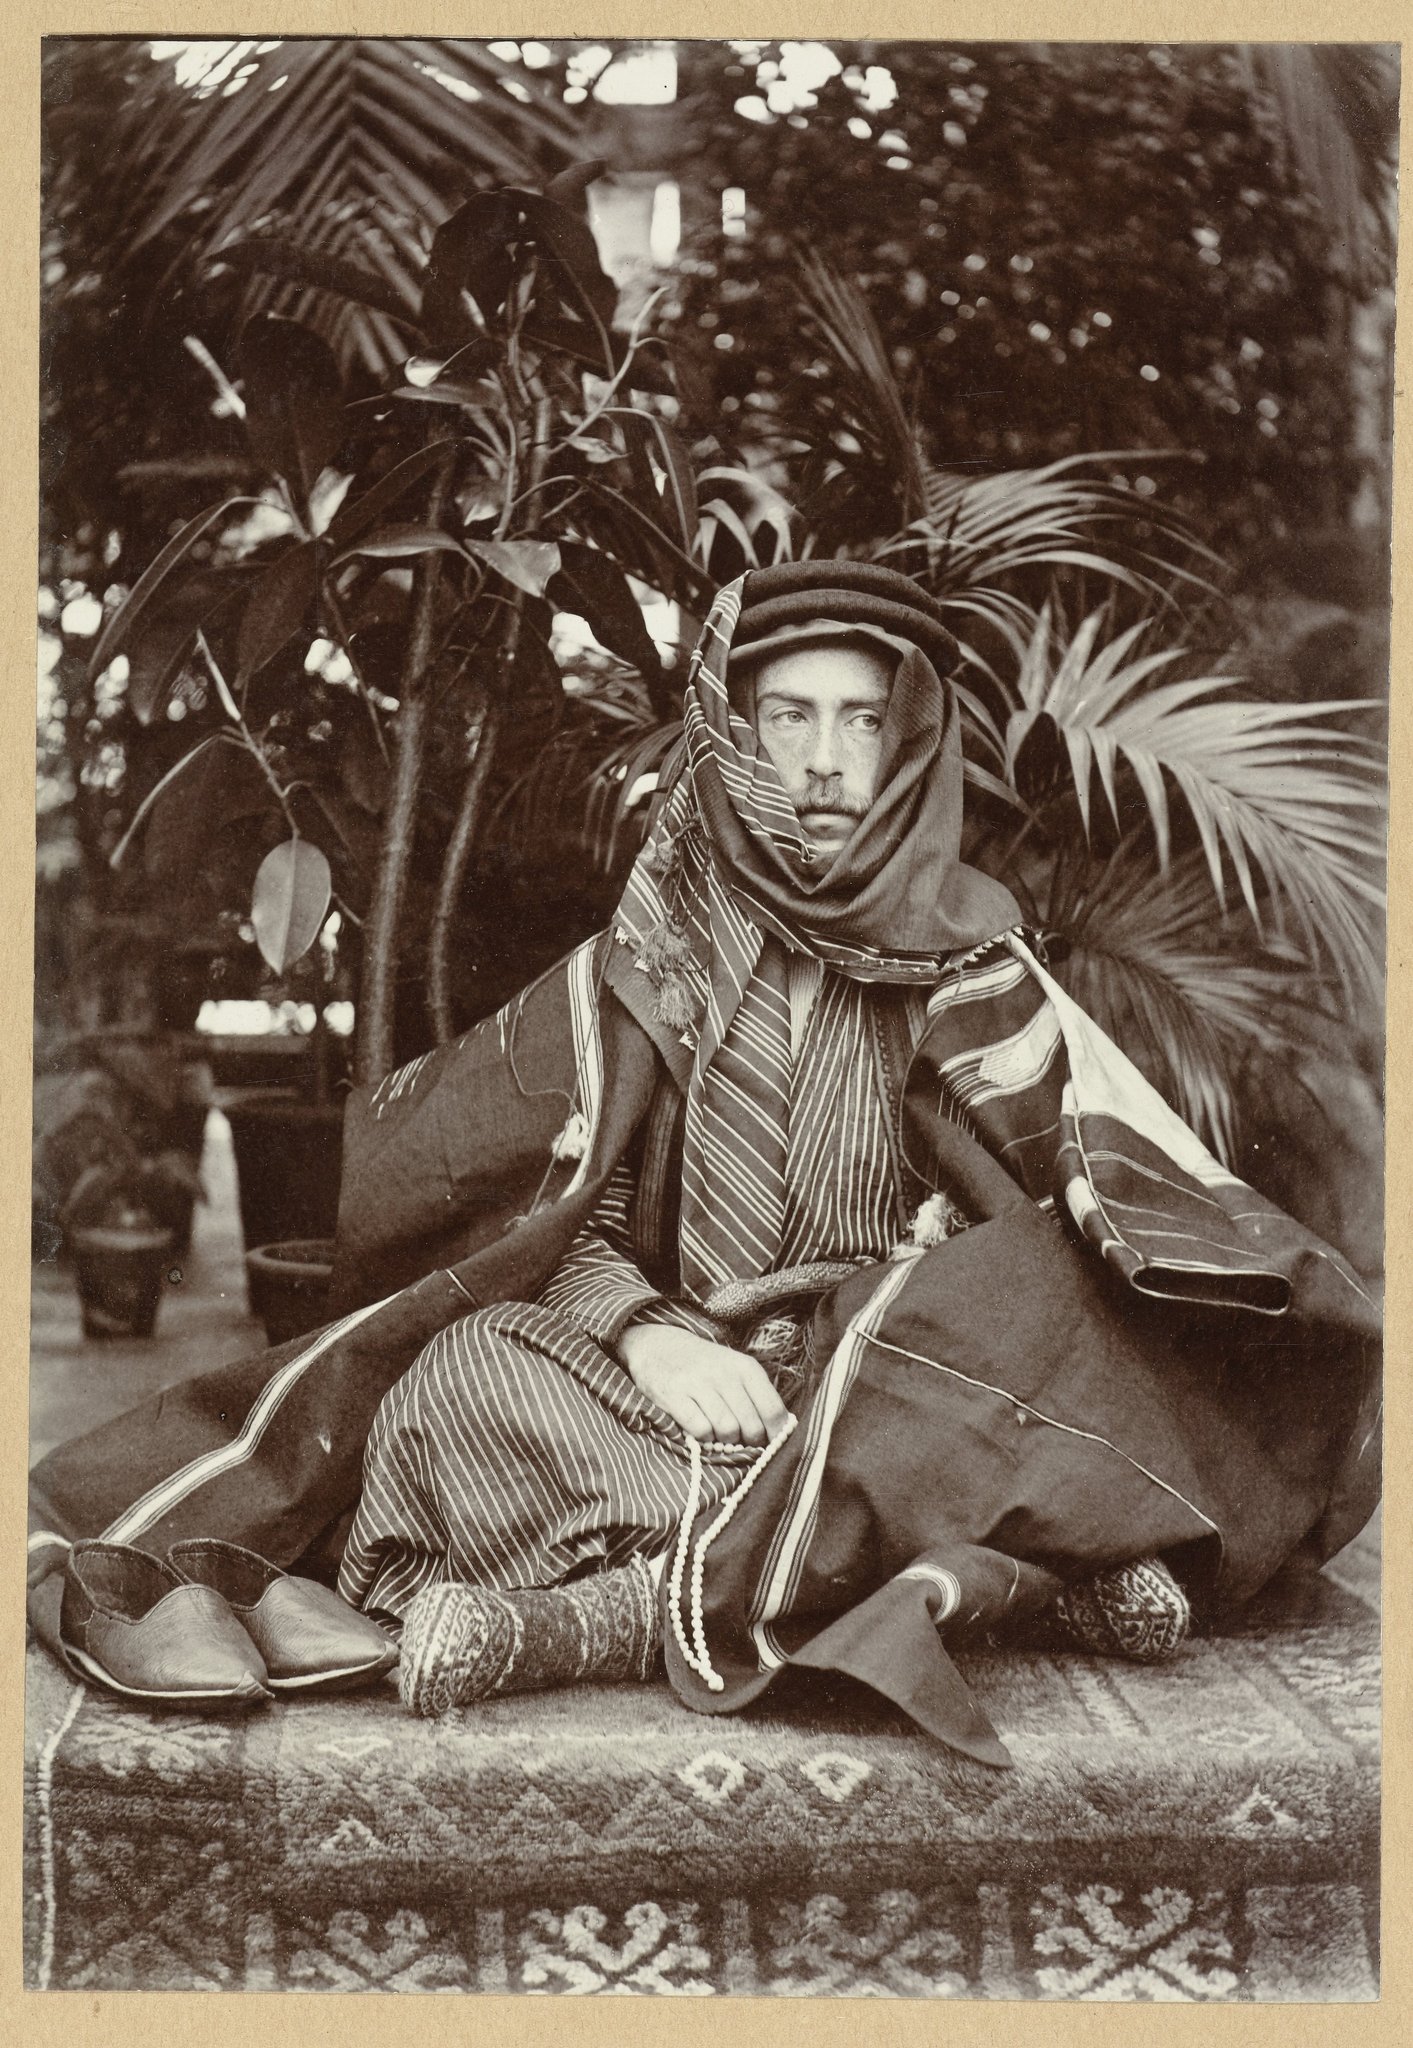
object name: photograph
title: LDB gekleed als cheikh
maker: mr. l. de bruyn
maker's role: fotograaf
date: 1900-1910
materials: paper, cardboard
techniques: collodion silver print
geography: egypt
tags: mr. l. de bruyn, historical persons, folk costume, regional costume, portrait, self-portrait of photographer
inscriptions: check stamp: ‘Bristol/ L.M.’, stamp: ‘Gemeentelijke bibliotheek/ Rotterdam’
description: De kleding van de geportretteerde past in het beeld dat in de "Westerse" verbeelding bestond (en bestaat) van de "Oriënt". Onderdeel van een groep door fotograaf Richard Polak op reis verzamelde foto’s. Deze foto is rond 1910 gemaakt door zijn reisgenoot mr. L. de Bruyn. Foto’s die hij op eerdere reizen verzamelde zijn tentoongesteld bij de Rotterdamsche Kunstkring (1895), Arti en Amicitiae te Amsterdam (1897-1898?) en Societeit 't Collegie te Kampen (datum vooralsnog onbekend).